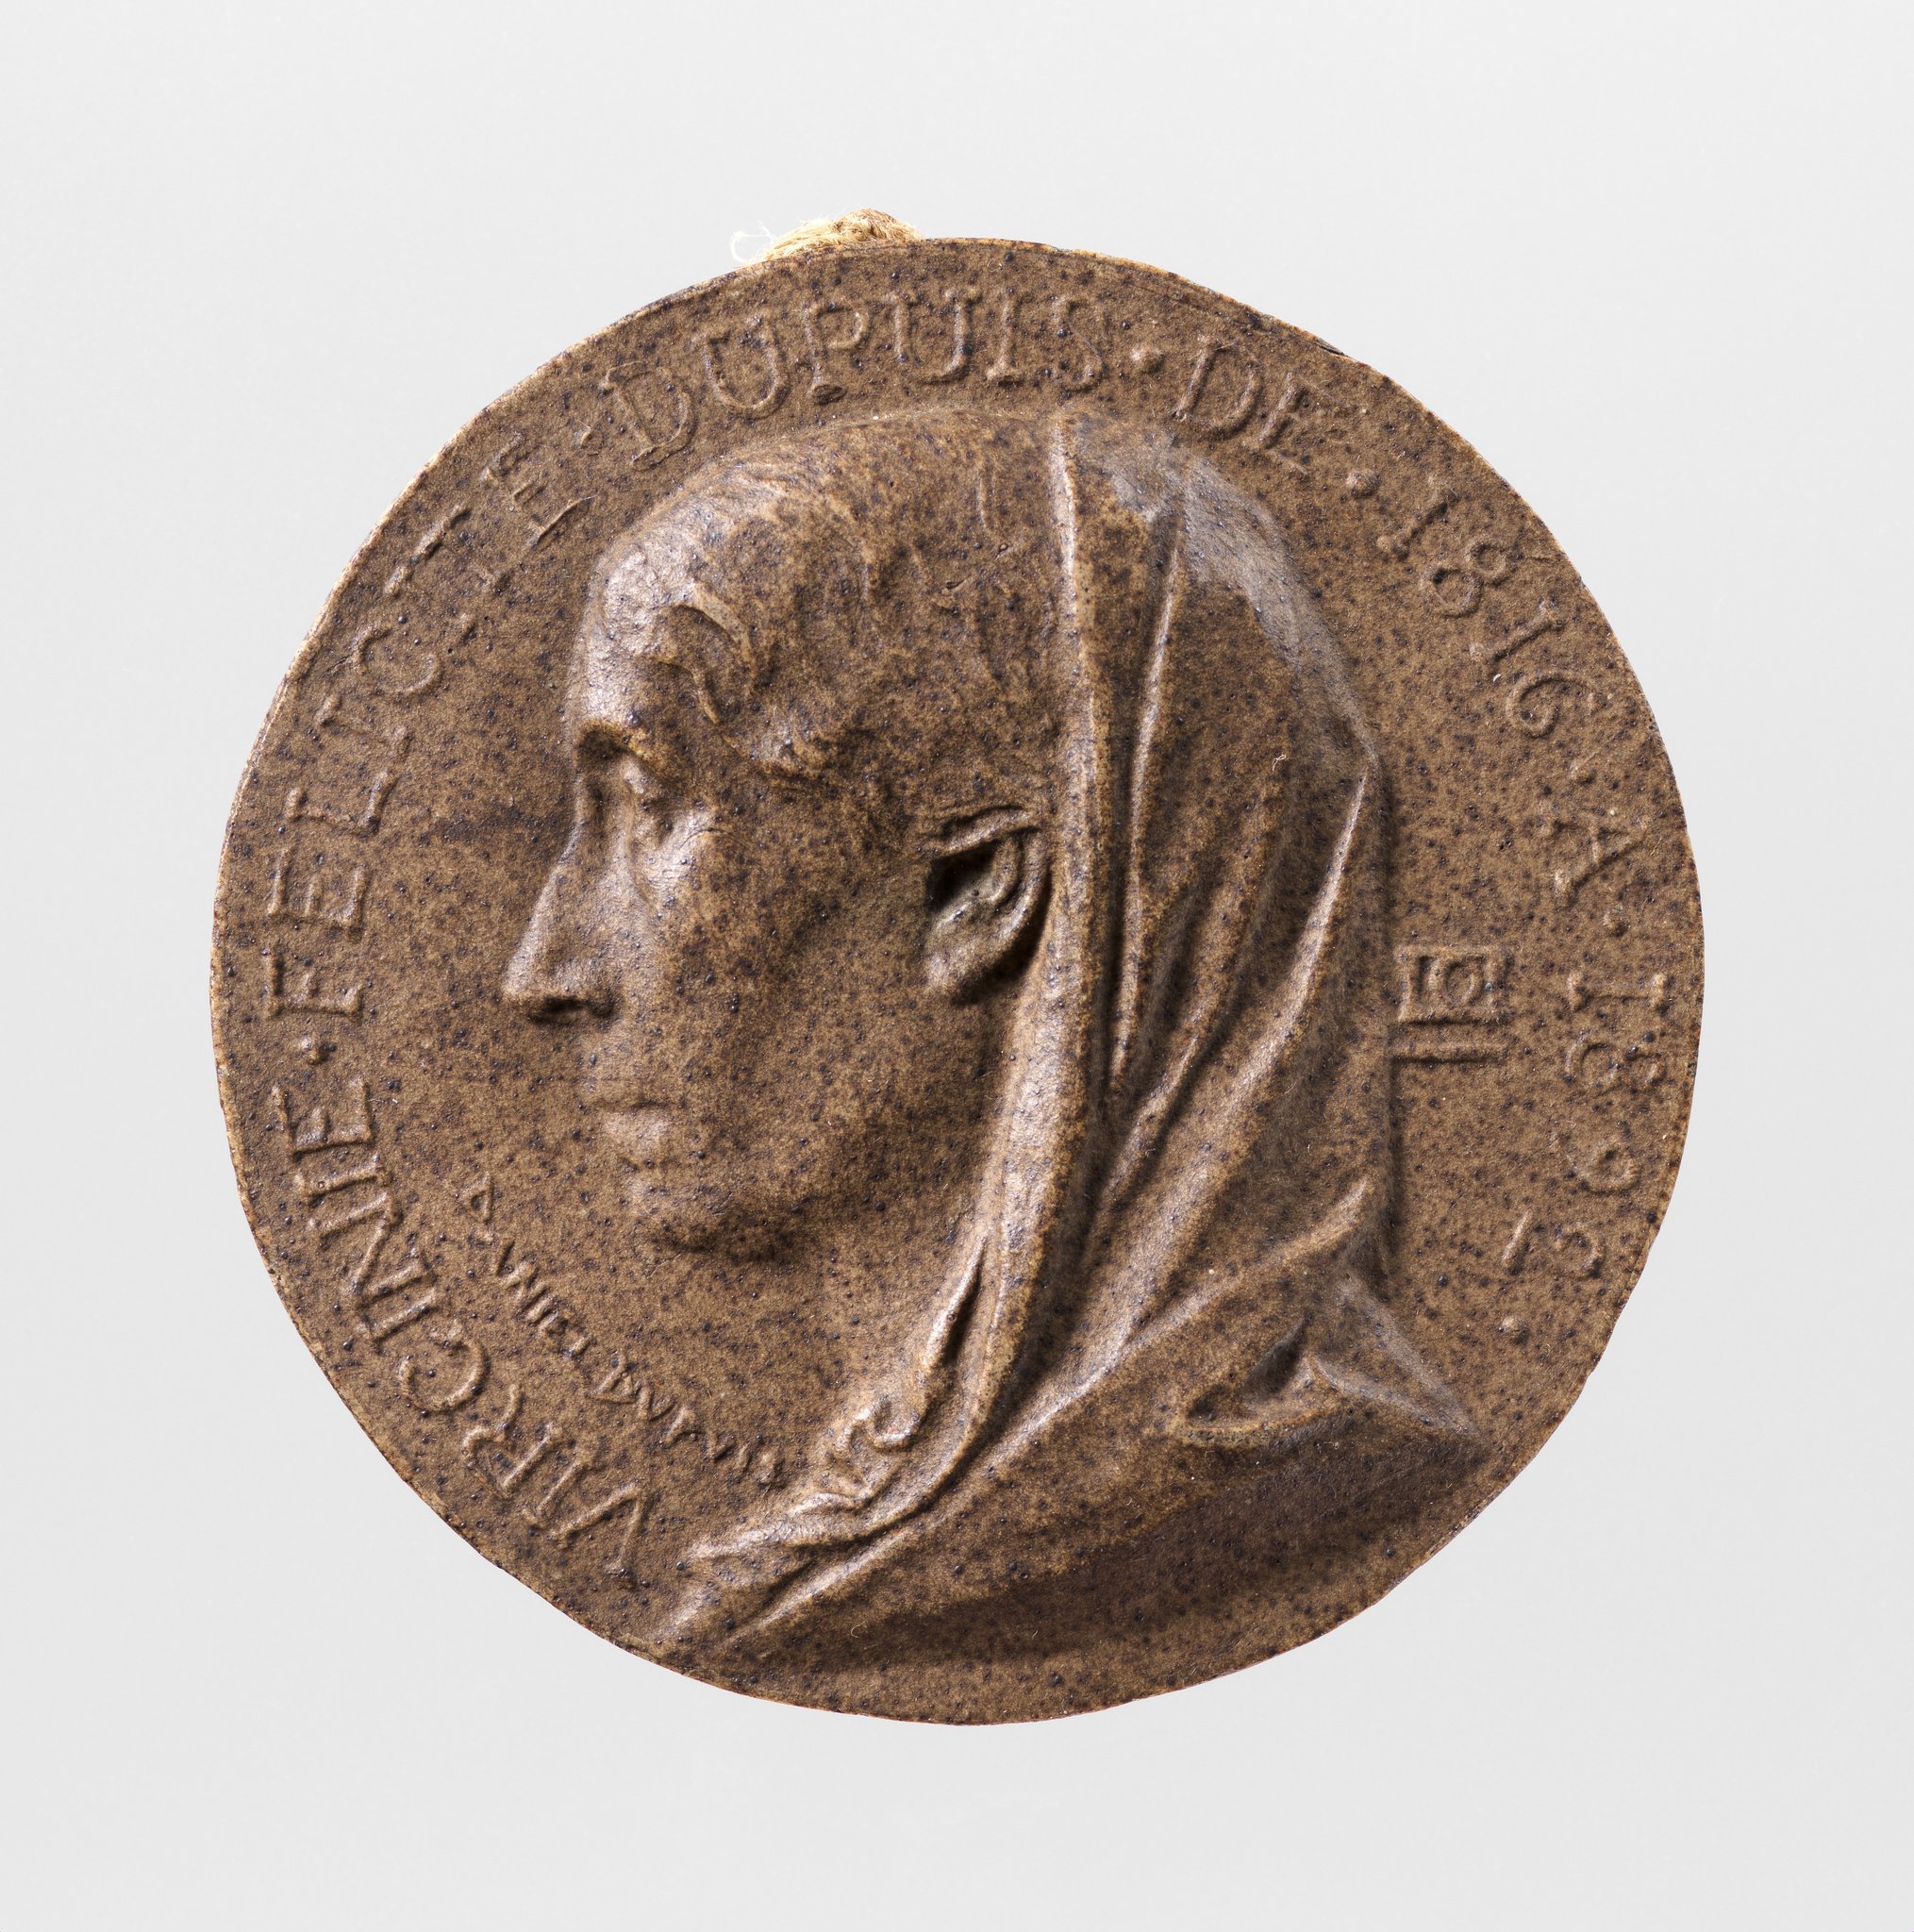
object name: medal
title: Portrait of the artist's mother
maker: daniel jean-baptiste dupuis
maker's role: maker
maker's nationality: french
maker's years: 1849-1899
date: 1892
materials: stoneware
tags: portraits,profiles,women